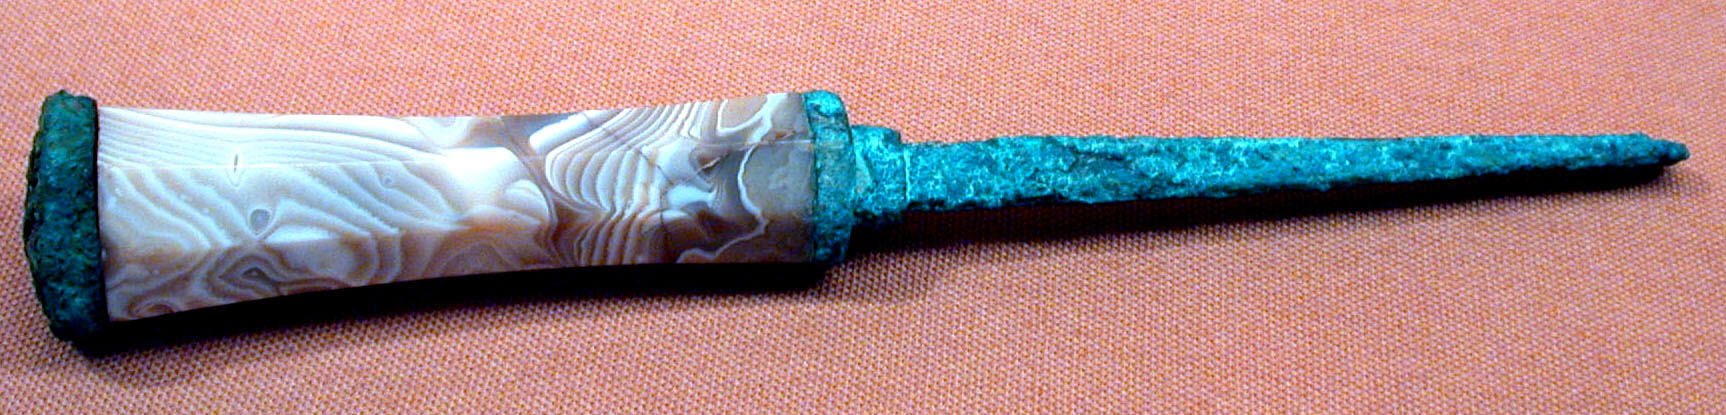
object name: handled implement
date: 1000-668 BCE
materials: stone, bronze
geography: transcaucasia